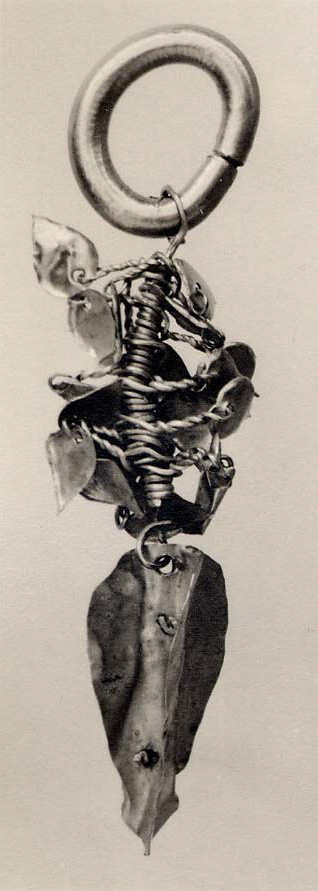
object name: earring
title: Earring (One of a Pair)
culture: korean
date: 401-600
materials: gold